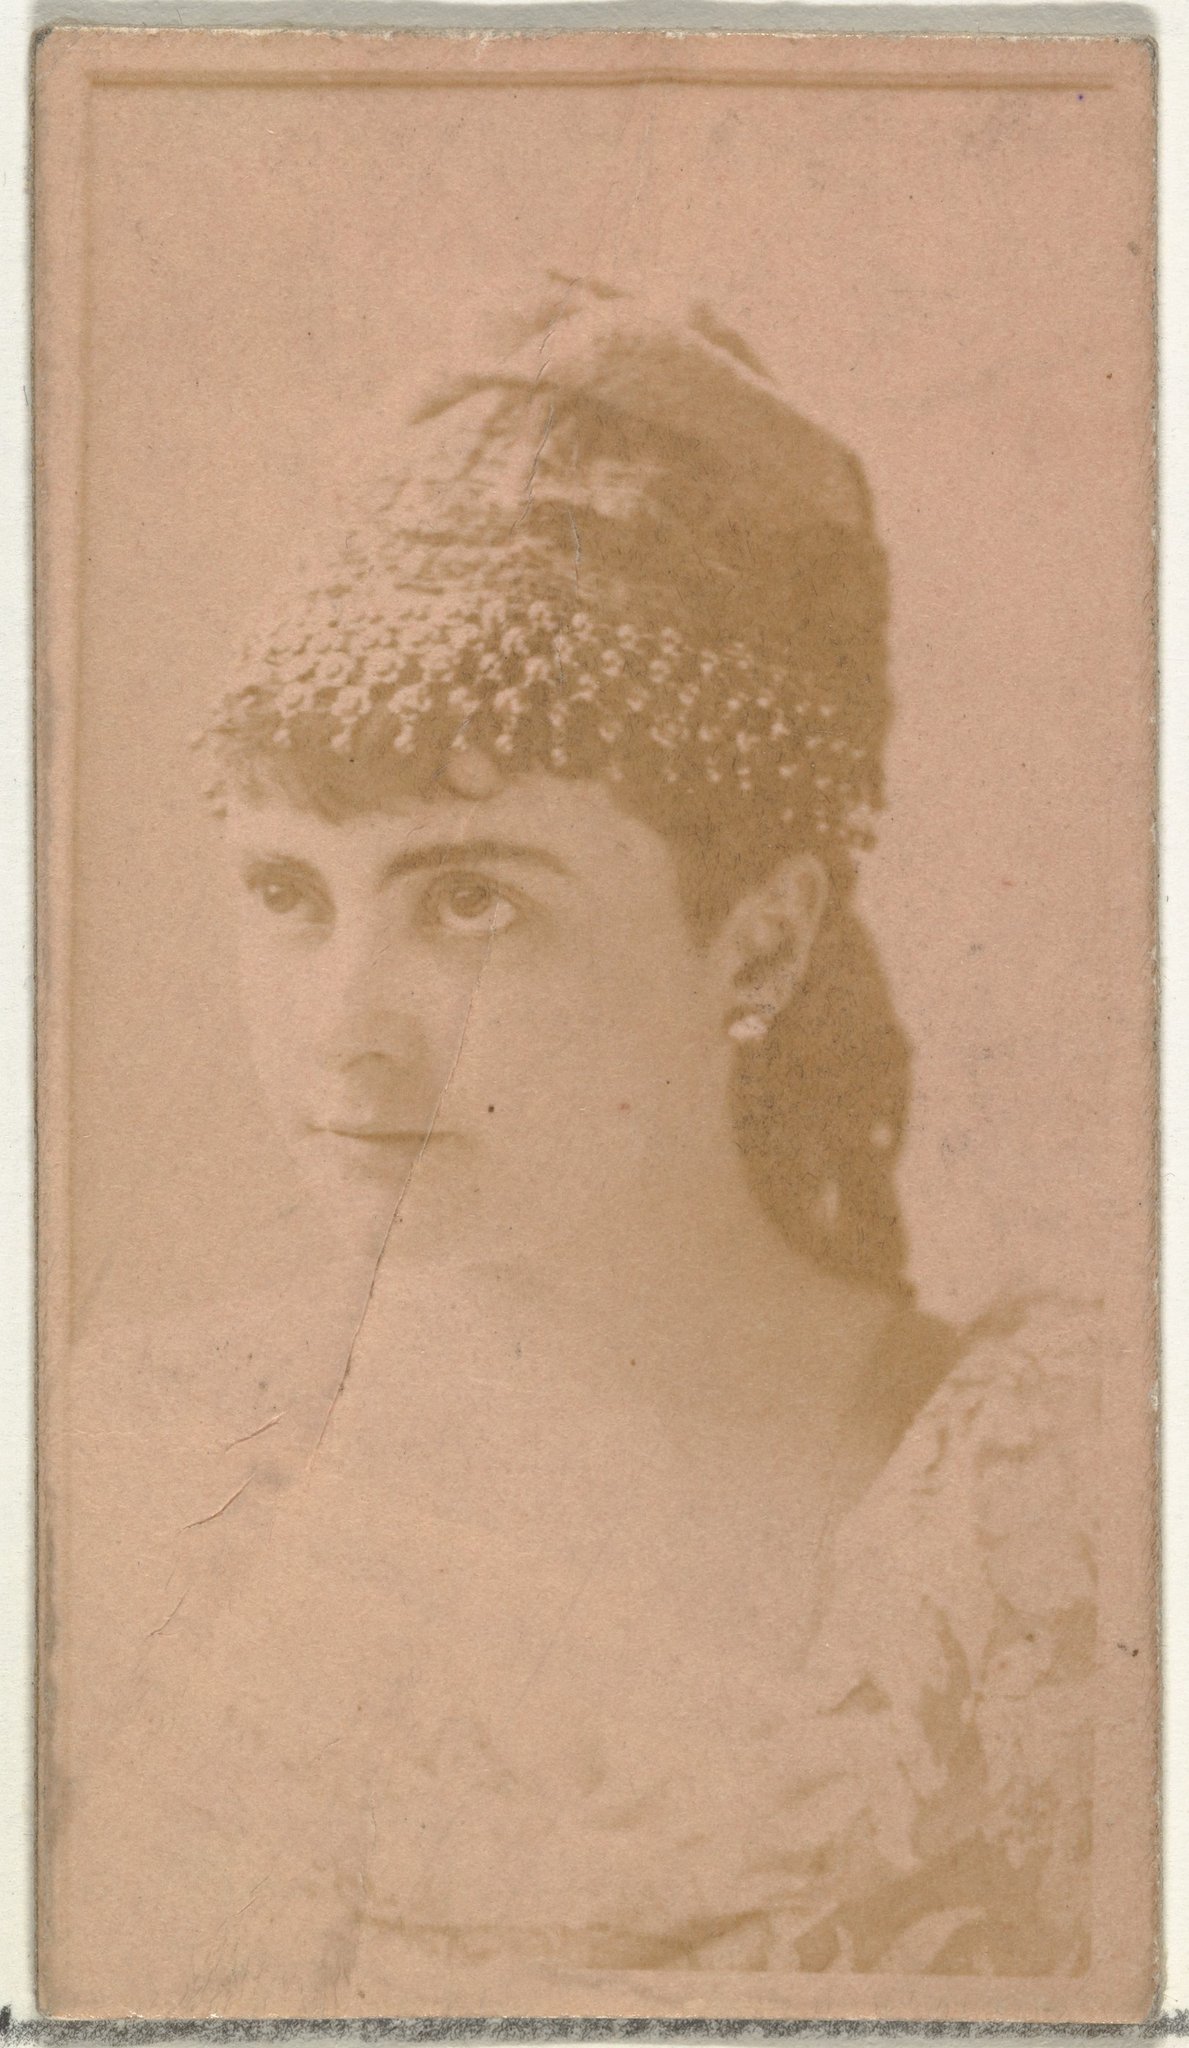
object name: photograph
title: [Actress wearing ornate cap], from the Actors and Actresses series (N145-8) issued by Duke Sons & Co. to promote Duke Cigarettes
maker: w. duke, sons & co.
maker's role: publisher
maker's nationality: american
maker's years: 1870-1920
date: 1891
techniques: albumen silver print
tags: portraits,women,actresses